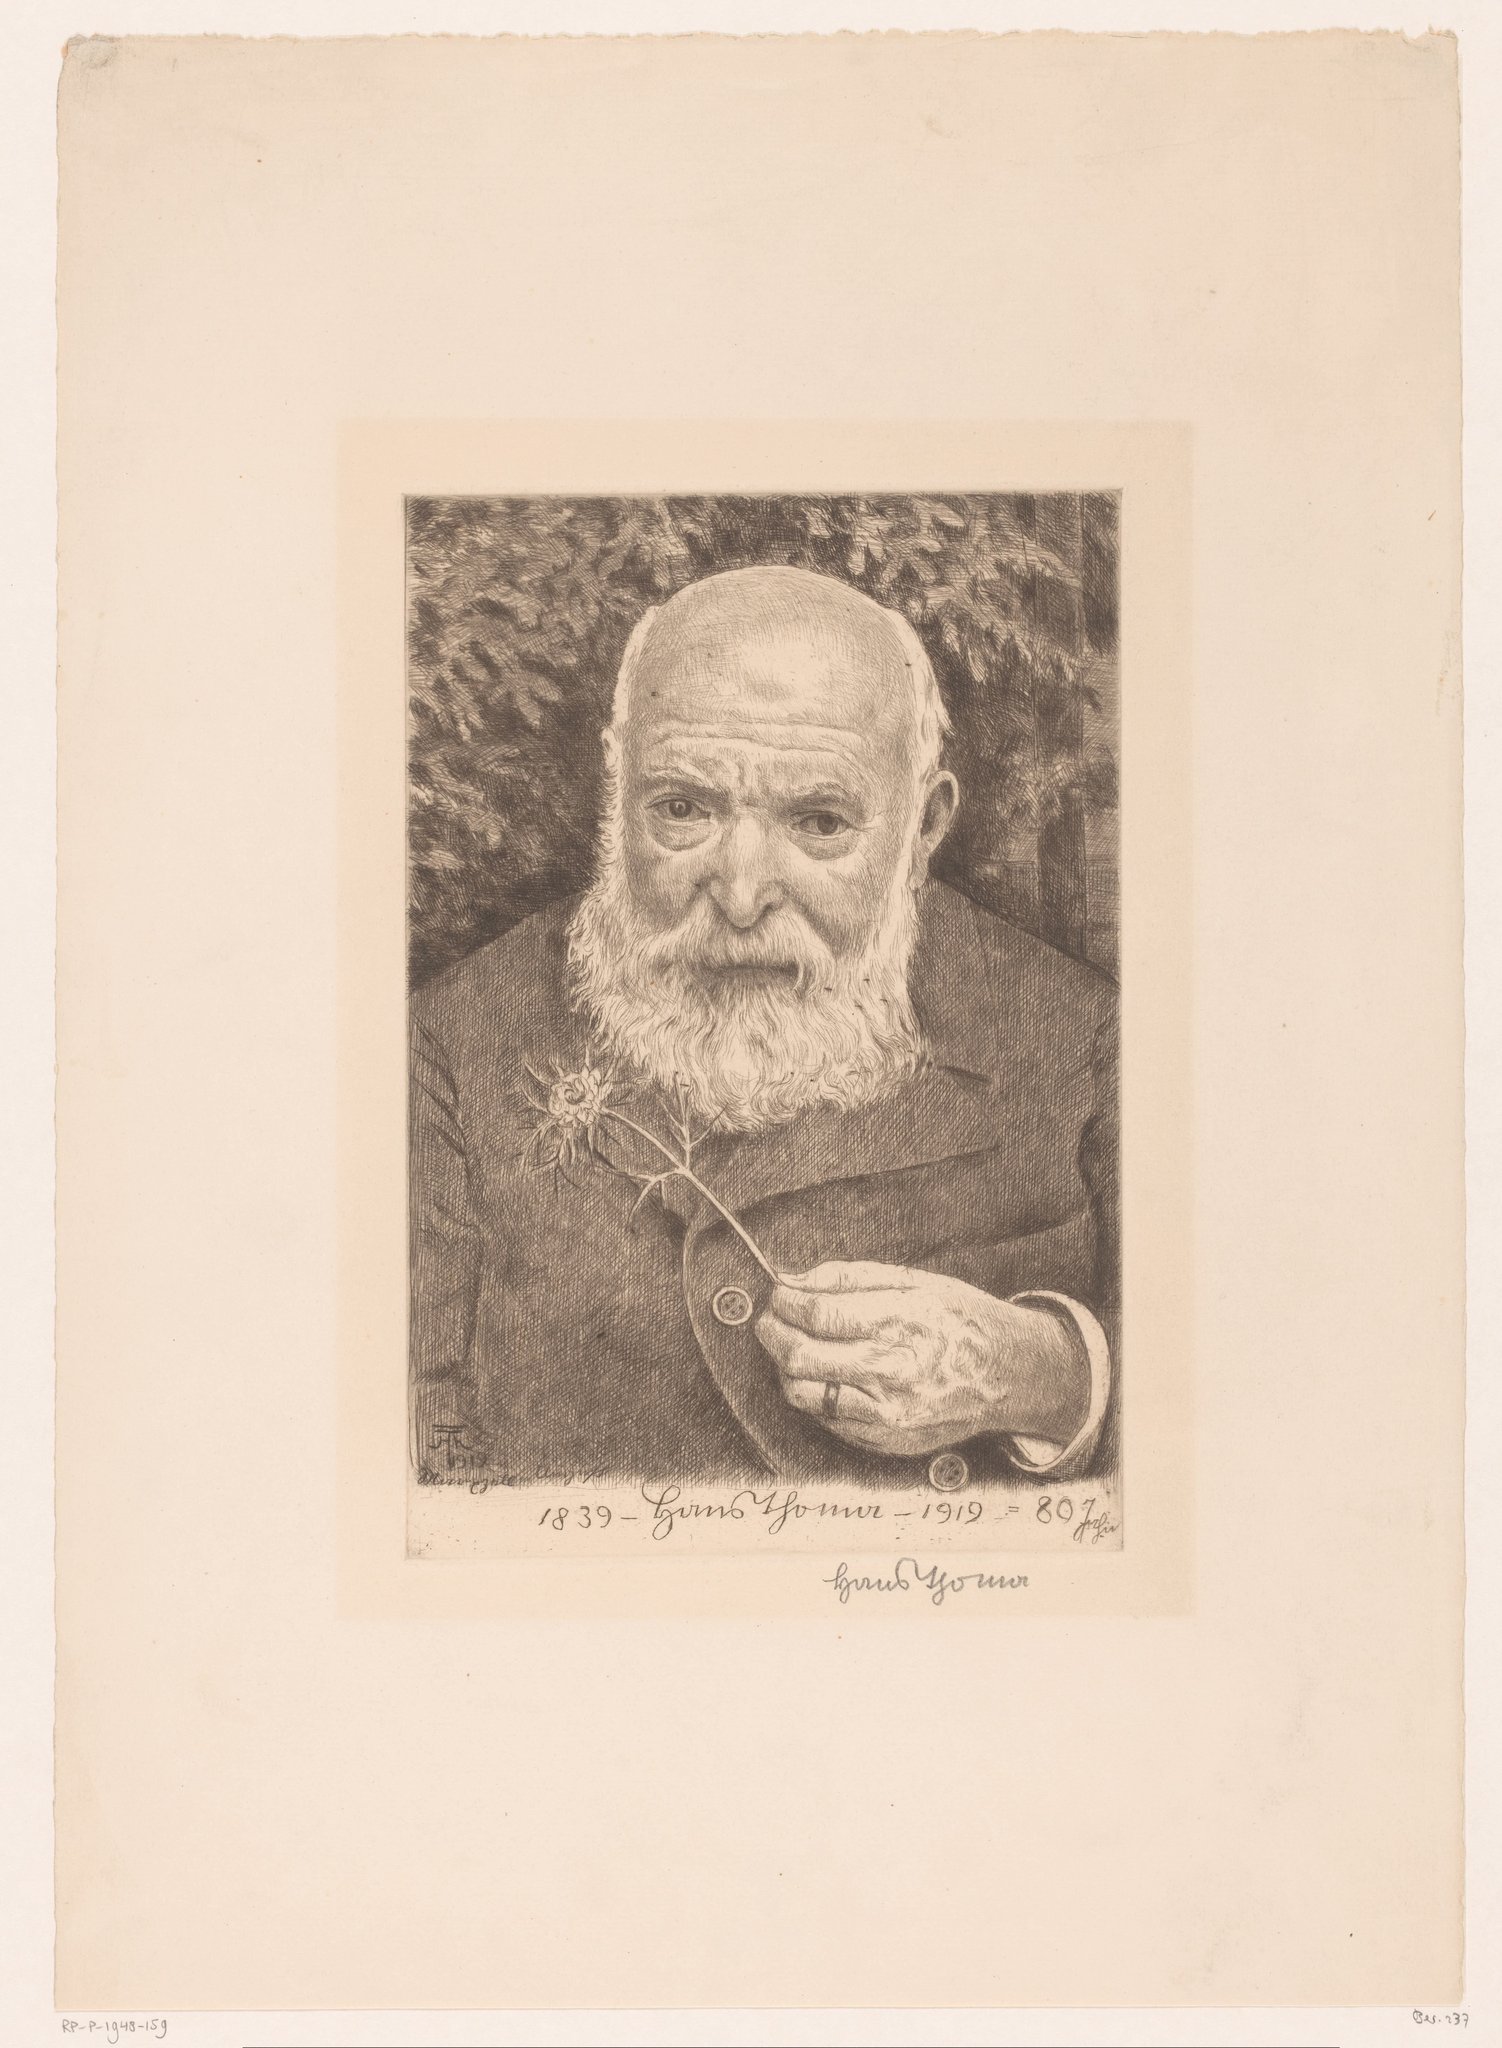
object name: print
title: Zelfportret met een distel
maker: hans thoma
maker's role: painter, print maker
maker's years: 1839-1924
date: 1919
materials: paper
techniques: drypoint, etching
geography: karlsruhe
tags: hans thoma, portrait, self-portrait of artist, beard, portrait, self-portrait of graphic artist, plants and herbs: thistle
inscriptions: collector's mark: Lugt 2228, collector's mark: Lugt 2760